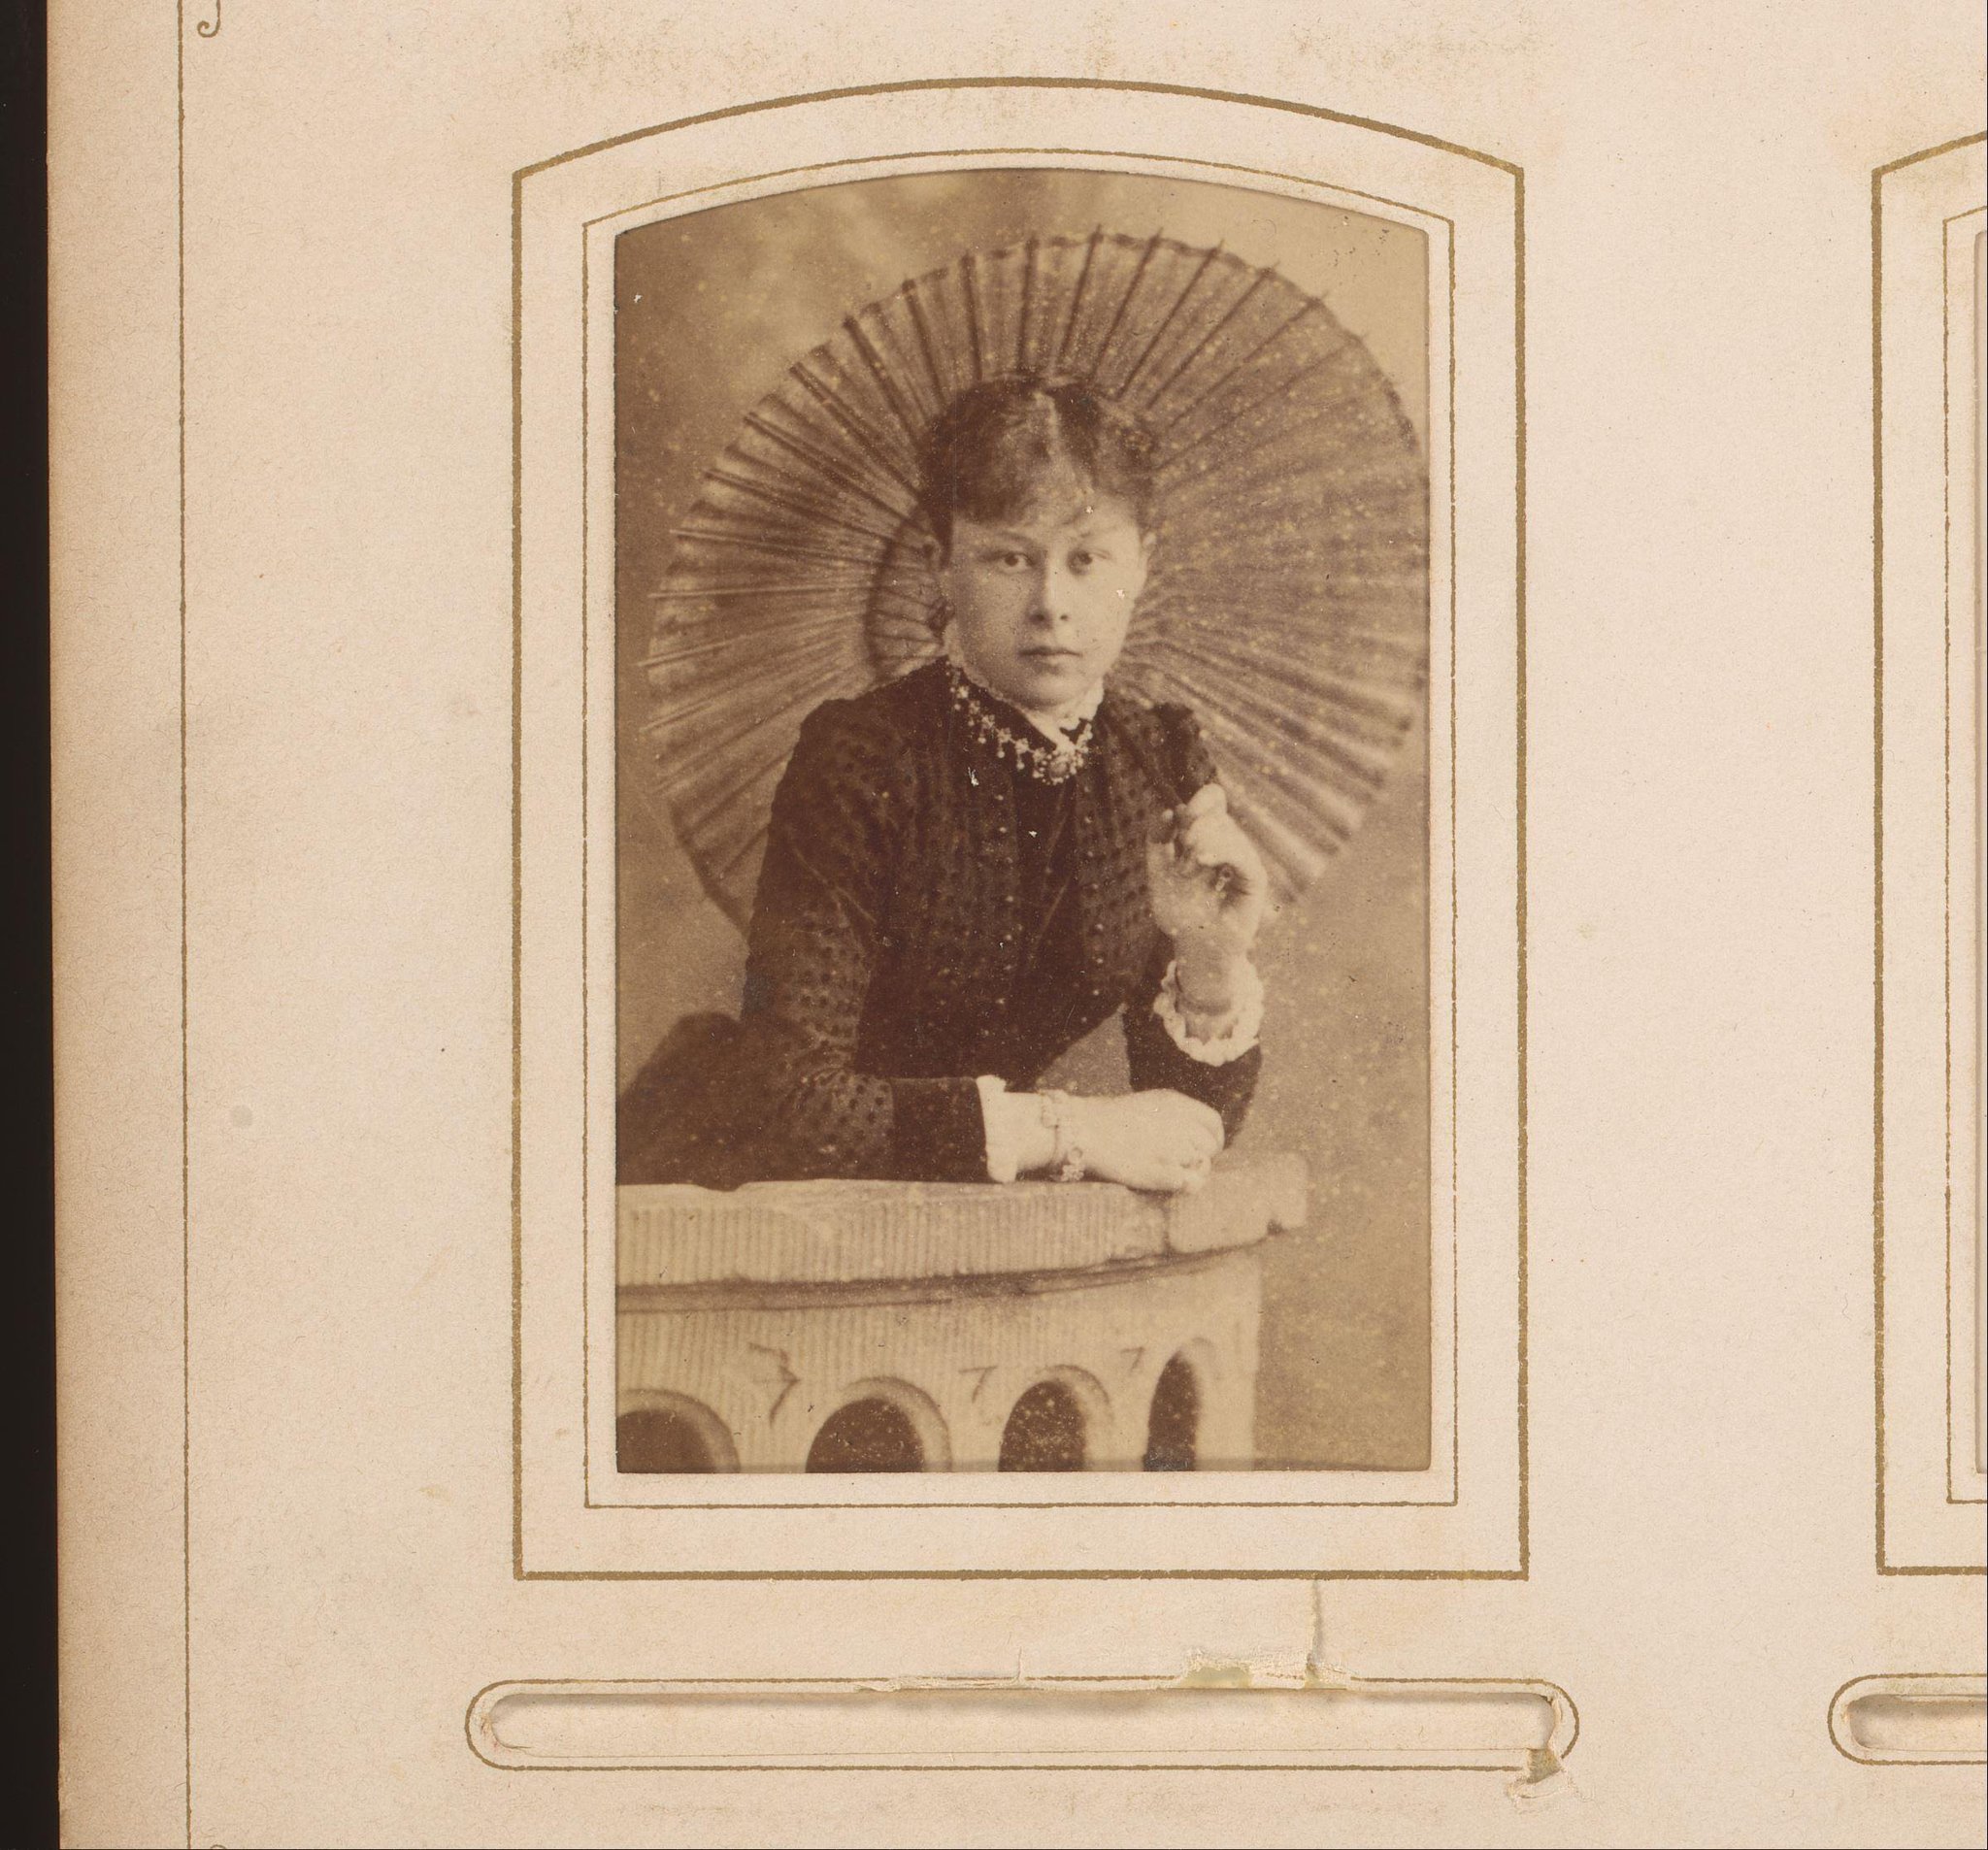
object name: photograph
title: Portret van een vrouw met parasol, leunend op een balustrade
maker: adolphe zimmermans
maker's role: fotograaf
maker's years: 1858-1922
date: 1885-1900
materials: cardboard, photographic support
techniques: albumen print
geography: the hague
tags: historical persons - bb - woman, balustrade, parasol, sunshade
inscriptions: inscription: ‘ANVERS 1885./ (...)/ Adolphe Zimmermans/ Photographe./ De Riemerstraat No. 21./ La Haye.’